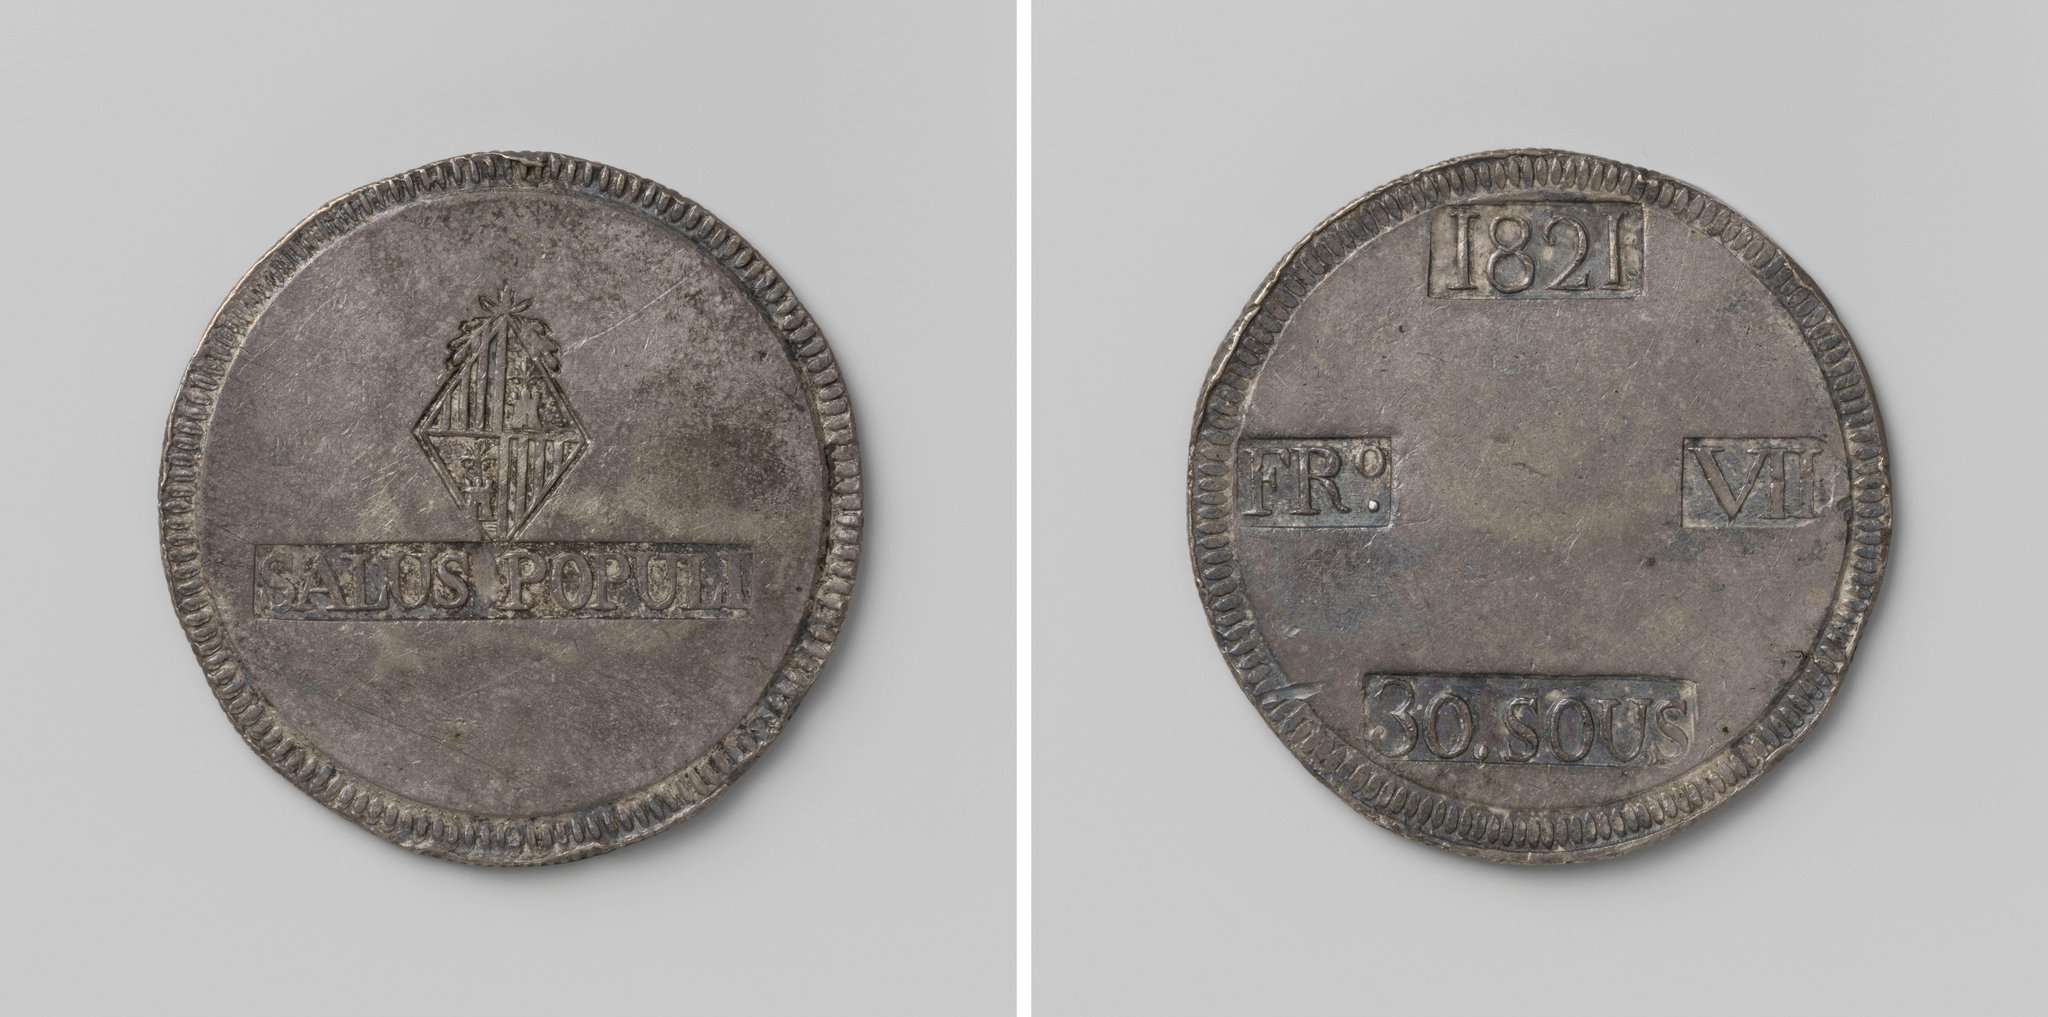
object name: dertig sou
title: Epidemie op Majorca, noodmunt van dertig sous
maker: Anonymous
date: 1821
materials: silver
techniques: striking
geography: majorca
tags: ferdinand vii (koning van spanje)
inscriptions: date